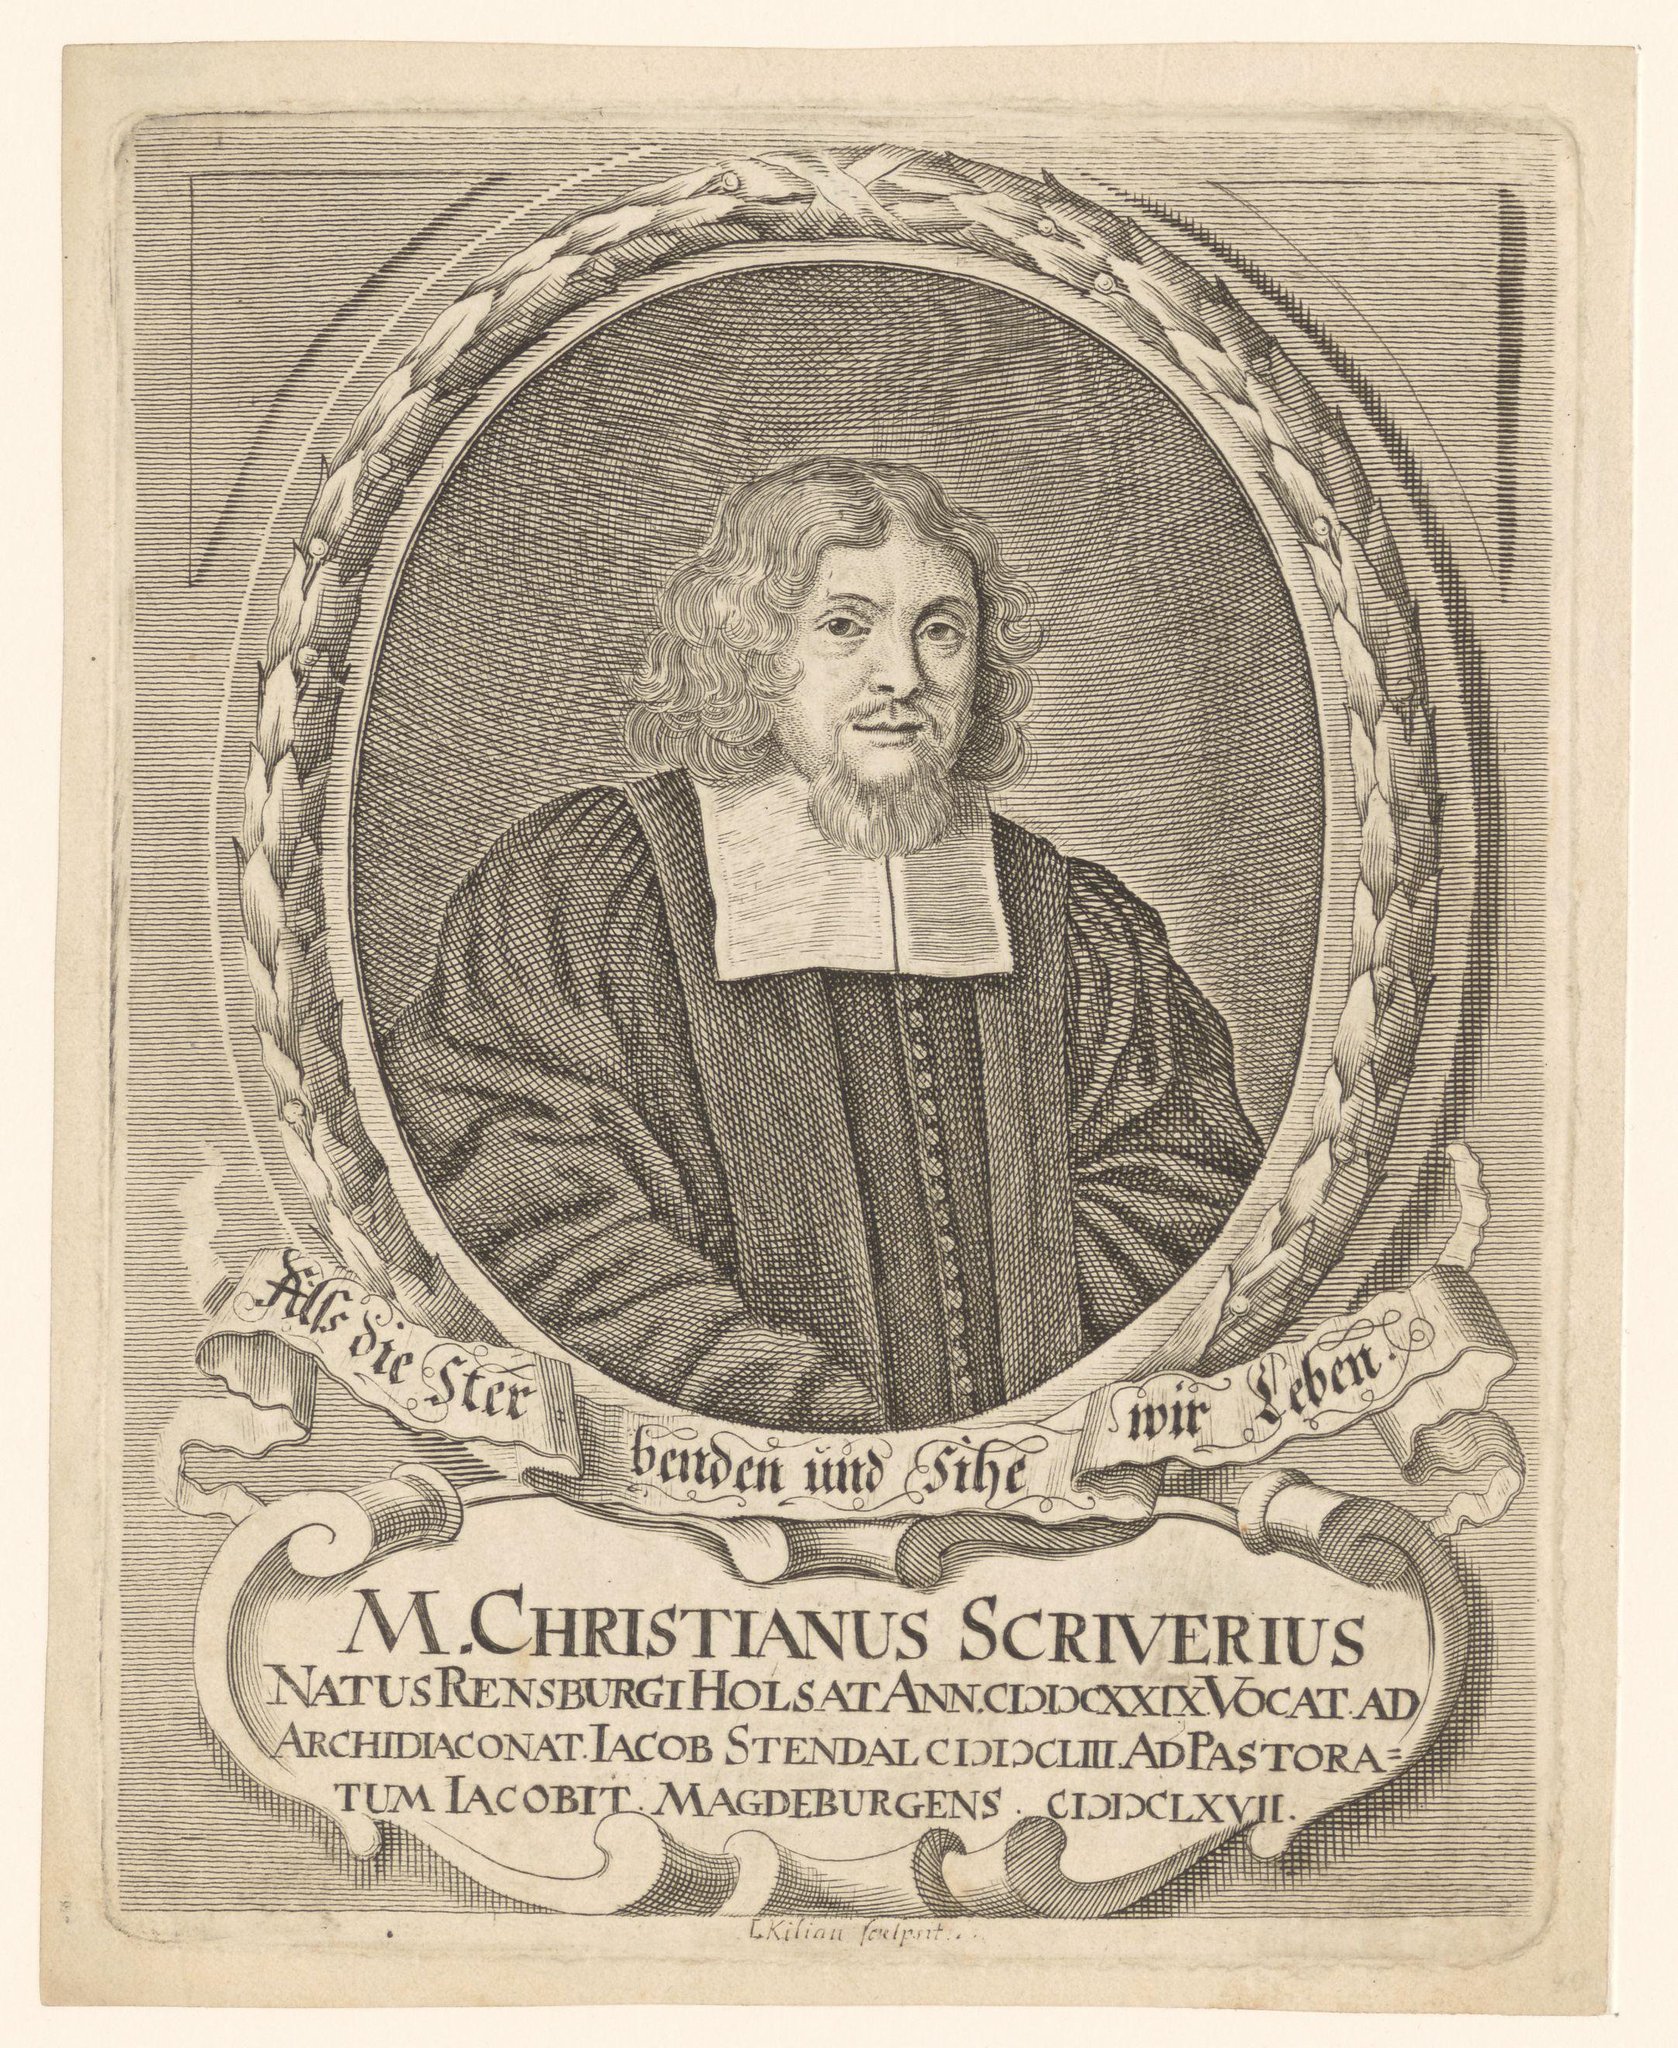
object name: print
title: Portret van Christian Scriver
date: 1677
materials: paper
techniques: engraving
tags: theologian, historical persons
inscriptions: collector's mark: Lugt 2228